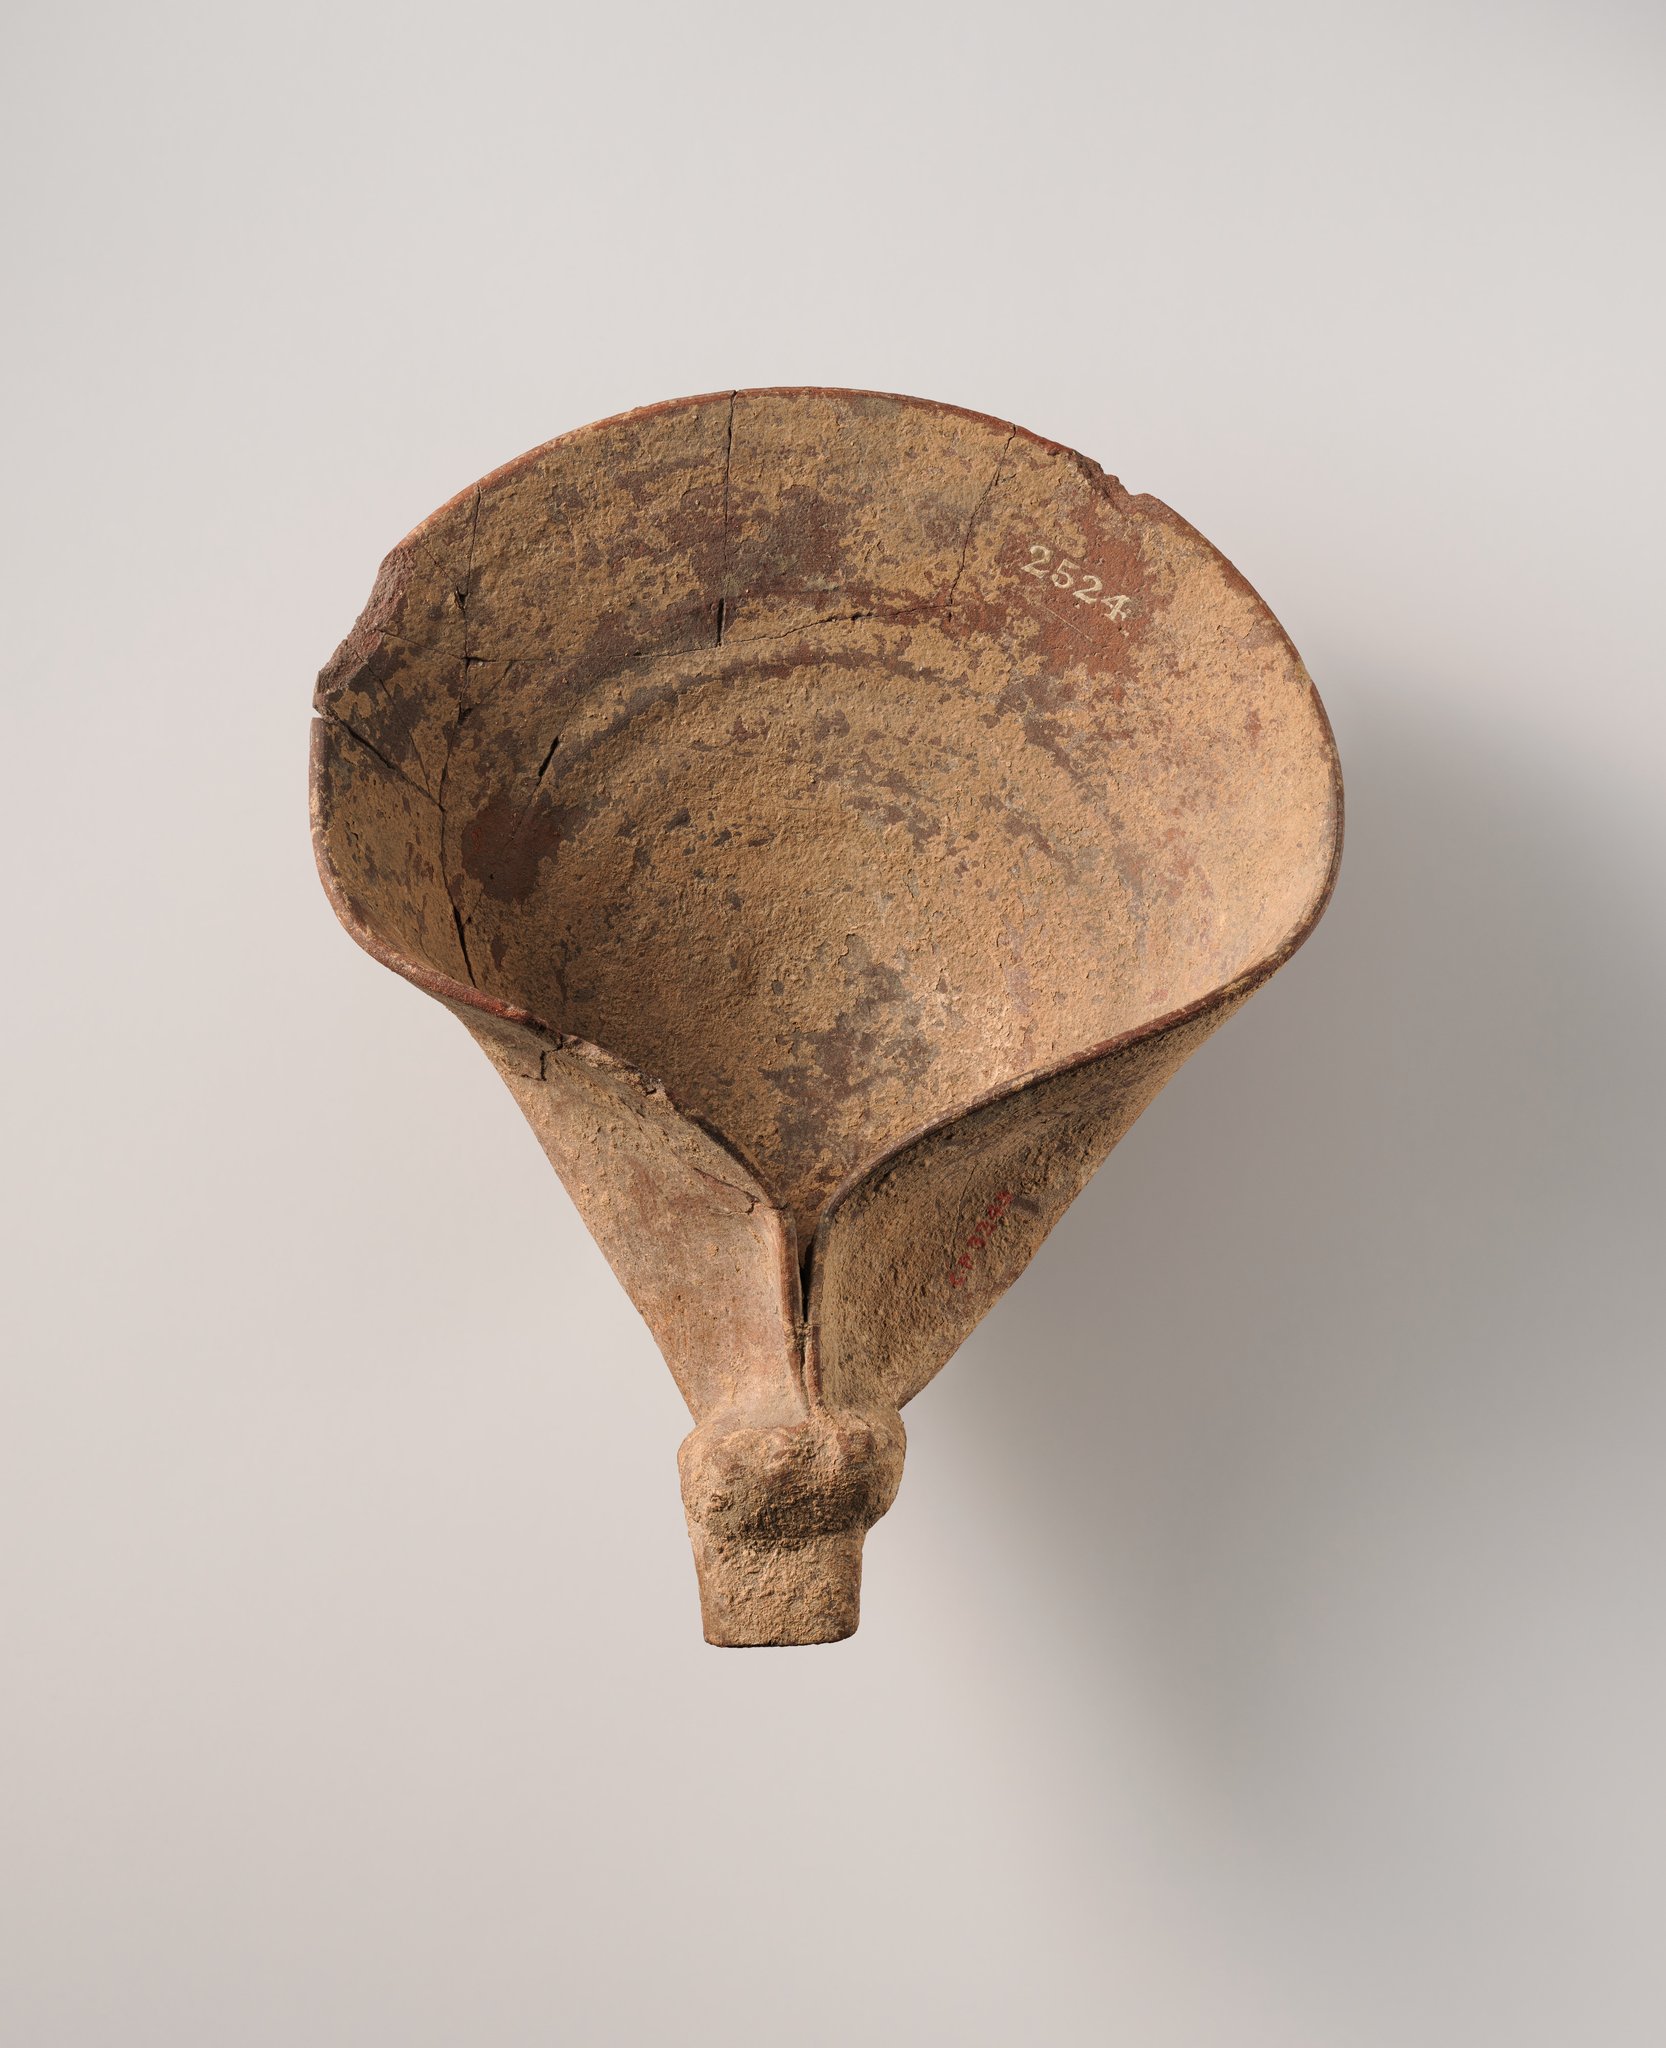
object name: ladle saucer, or shovel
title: Terracotta ladle-saucer or shovel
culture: cypriot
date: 400-301 BCE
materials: terracotta